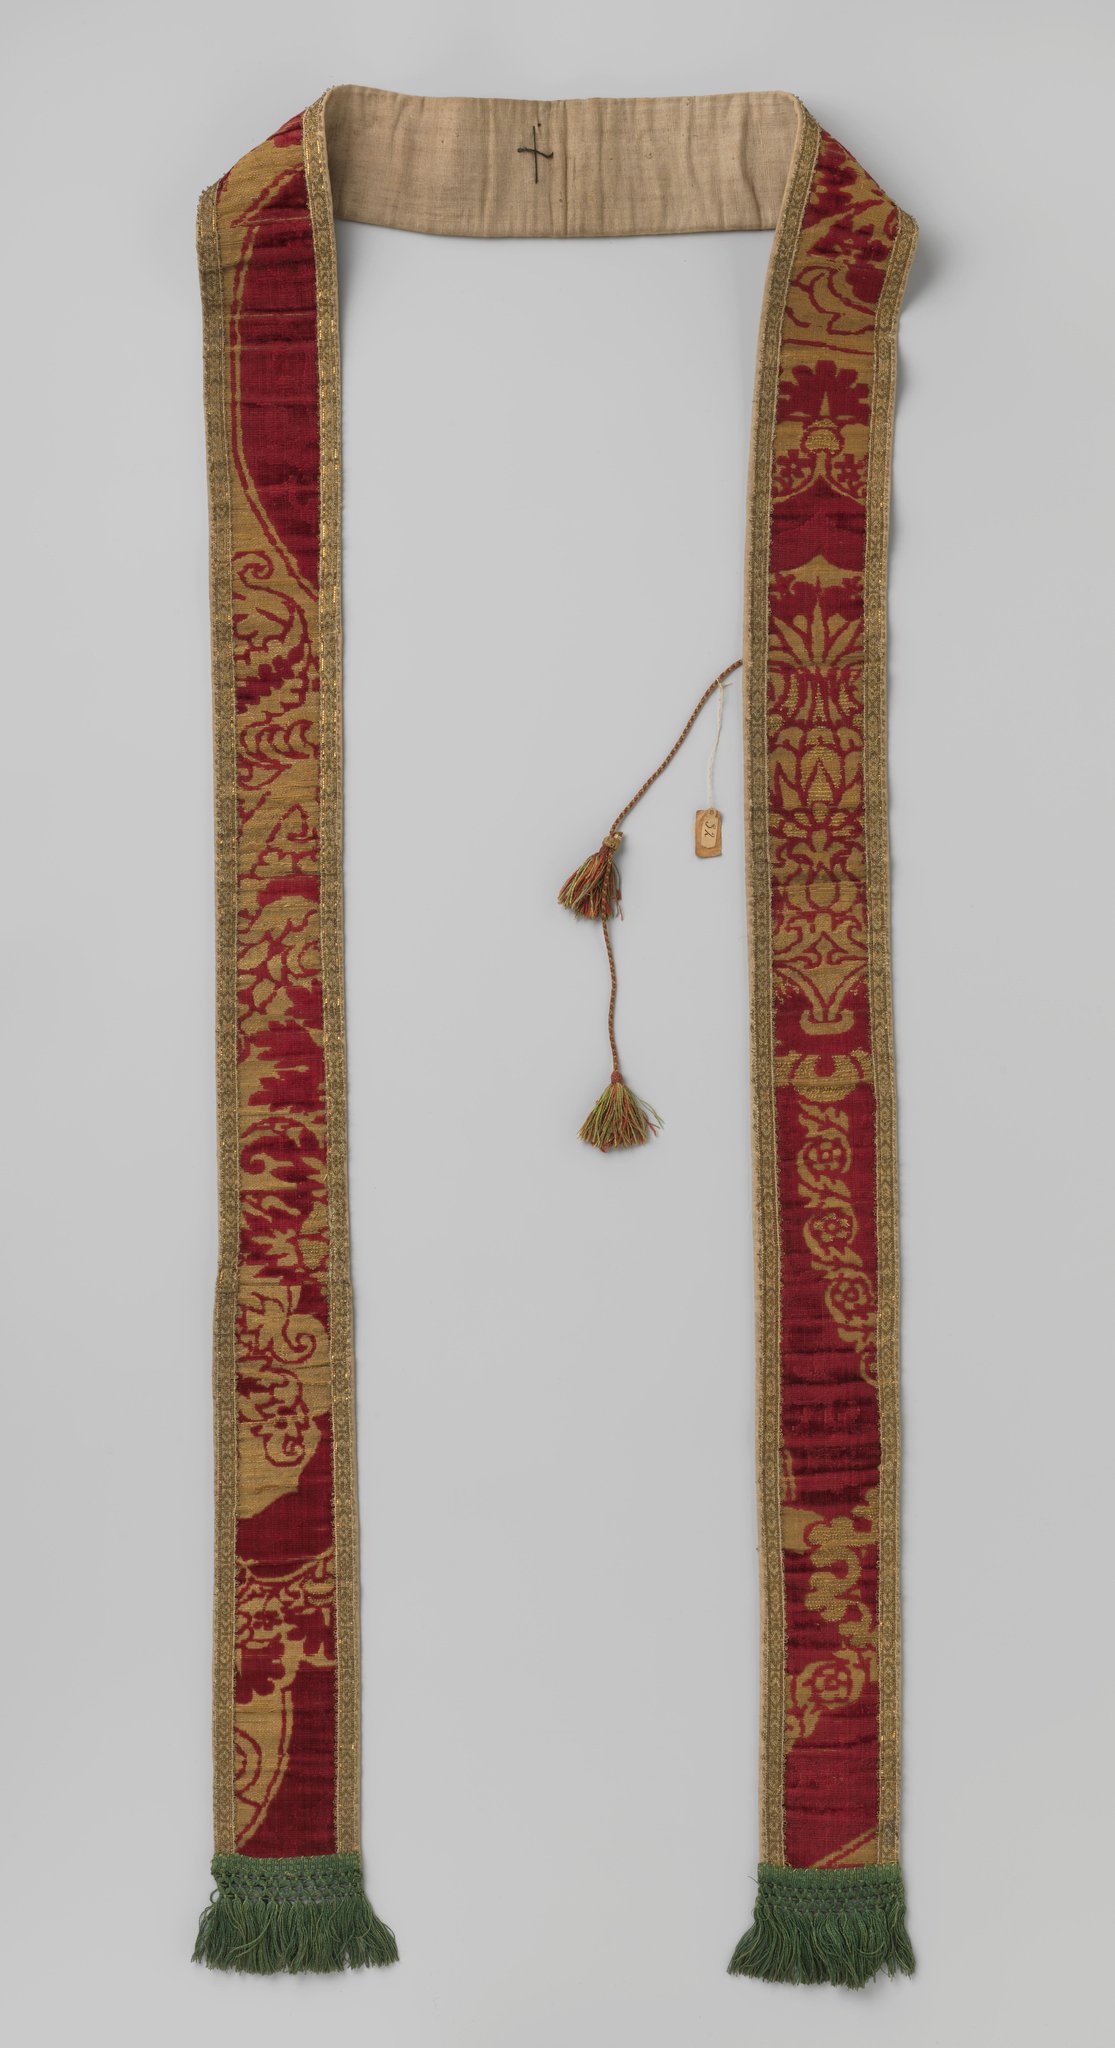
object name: stola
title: Stola, van rood fluweel en gouddraad, goudpassement en groene franje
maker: Anonymous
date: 1000-1999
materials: gold thread, textile, velvet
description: Stola van rood fluweel en gouddraad, goudpassement en groene franje aan uiteinden.